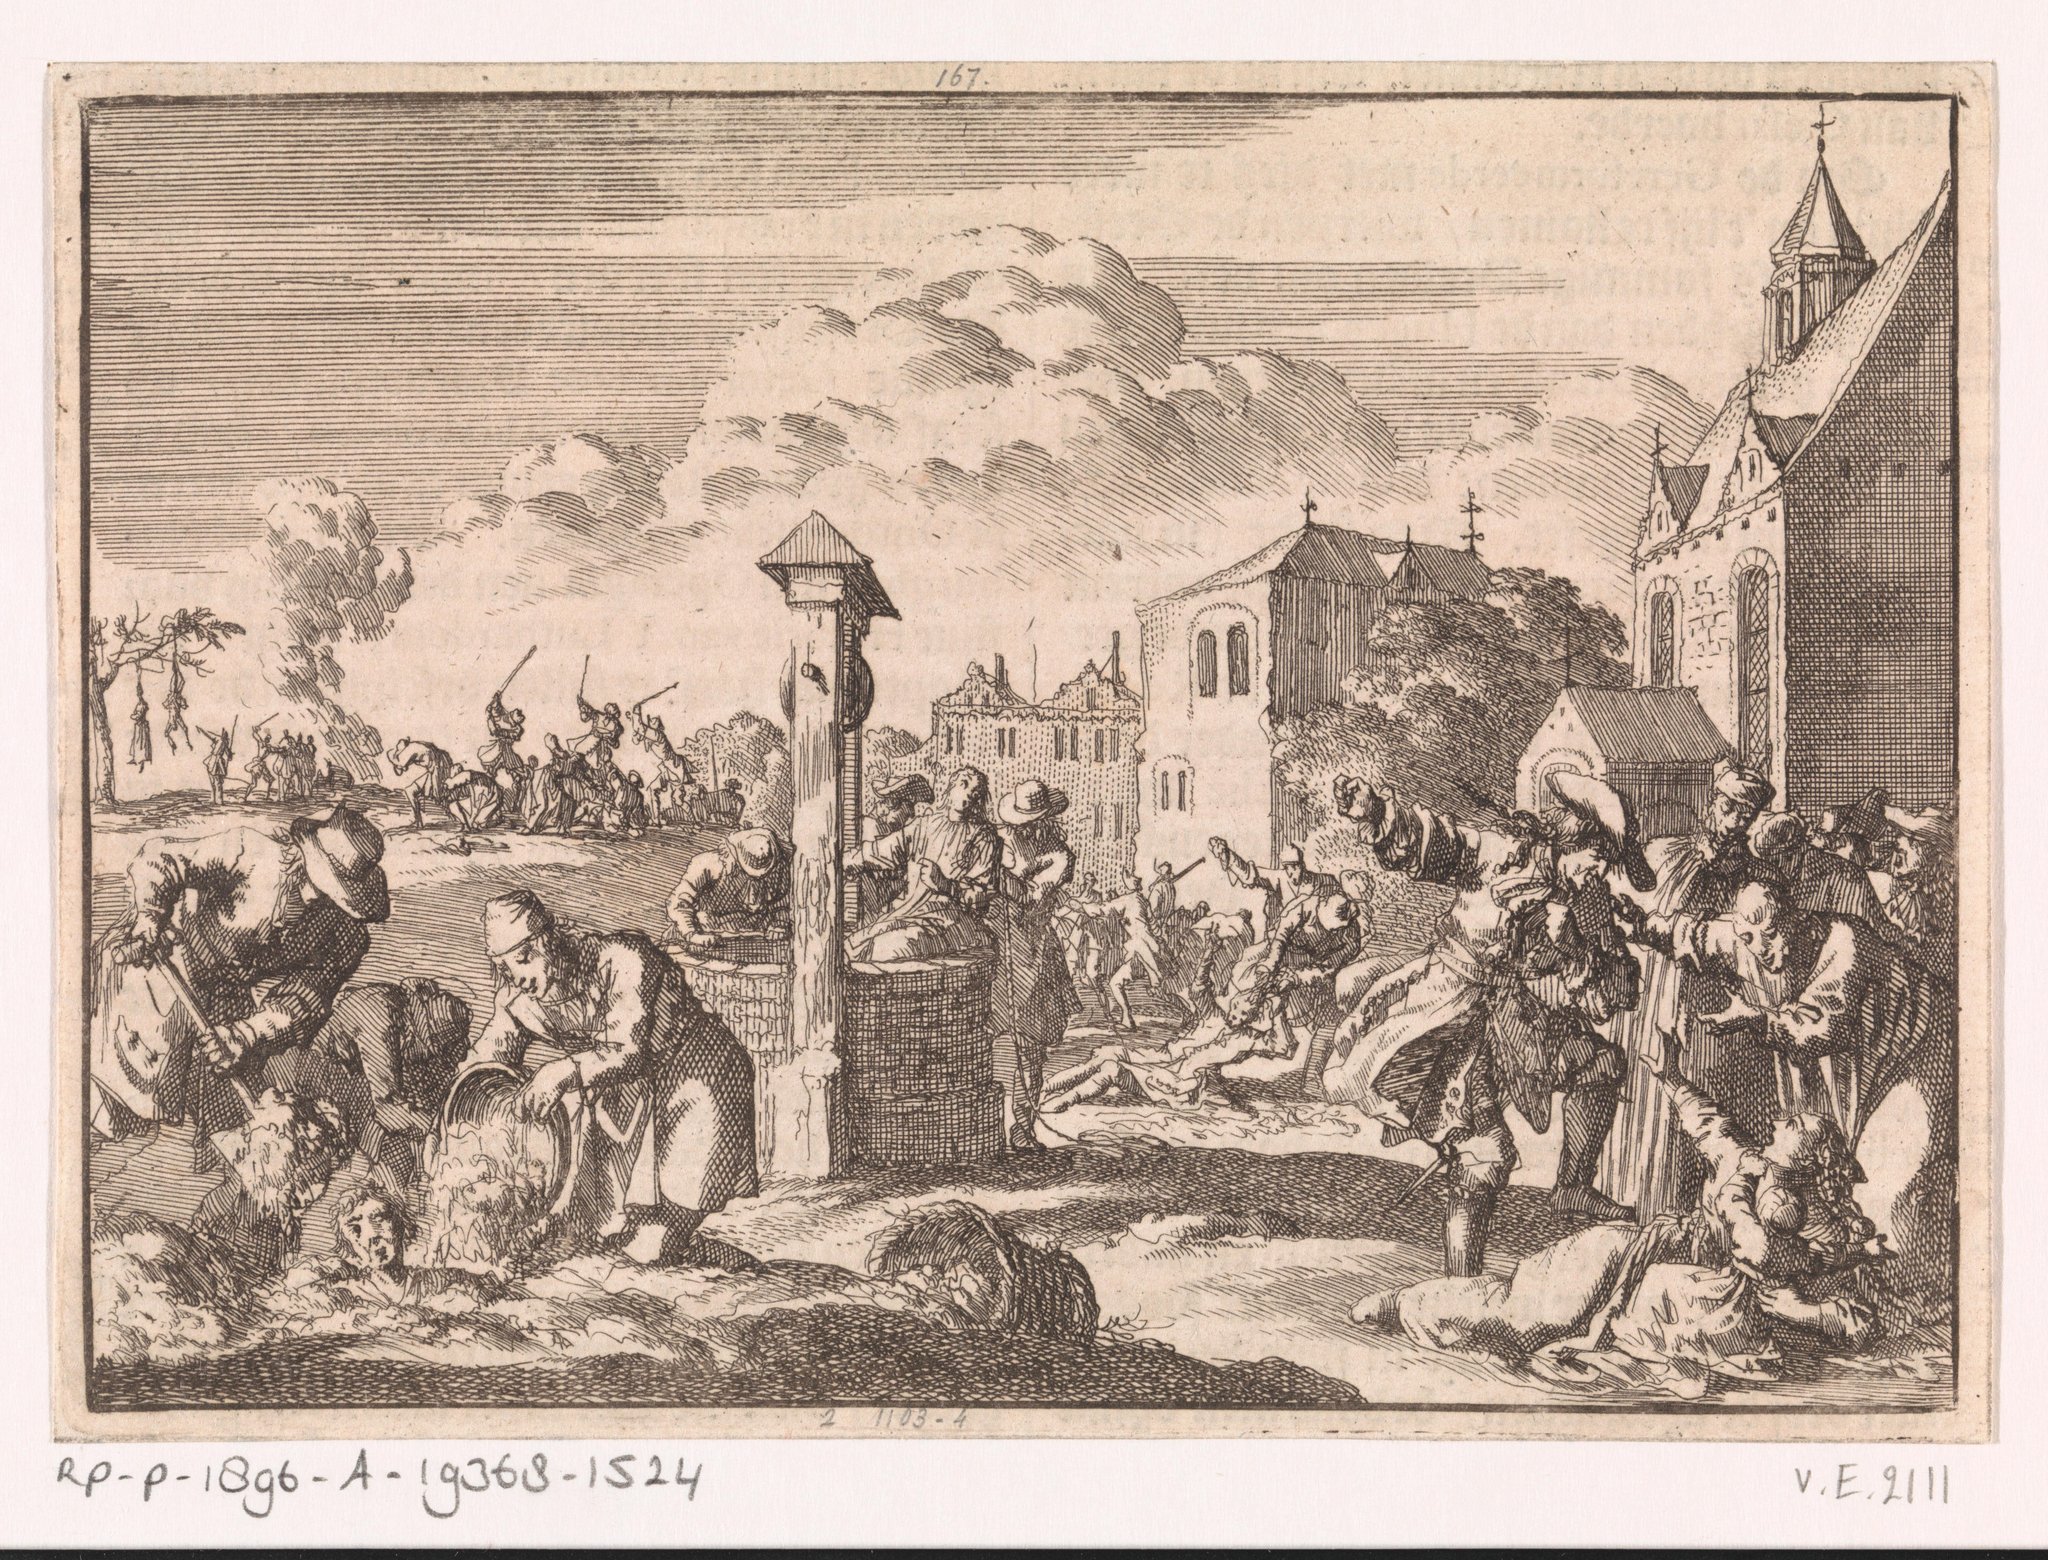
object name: print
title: Vervolging van protestanten door Marsaut te Niort, 1682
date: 1698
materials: paper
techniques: etching, letterpress printing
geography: amsterdam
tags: persecution of believers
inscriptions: collector's mark: Lugt 2228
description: Illustratie uit: Gottfried, Johann Ludwig. Historische kronyck; vervattende een (...) beschrijvingh der aldergedenckwaerdigste geschiedenissen des weerelds, van den aenvangh der scheppingh tot (...) 1576 (2 delen). Leiden: Pieter van der Aa, 1698, dl. II, p. 1103.